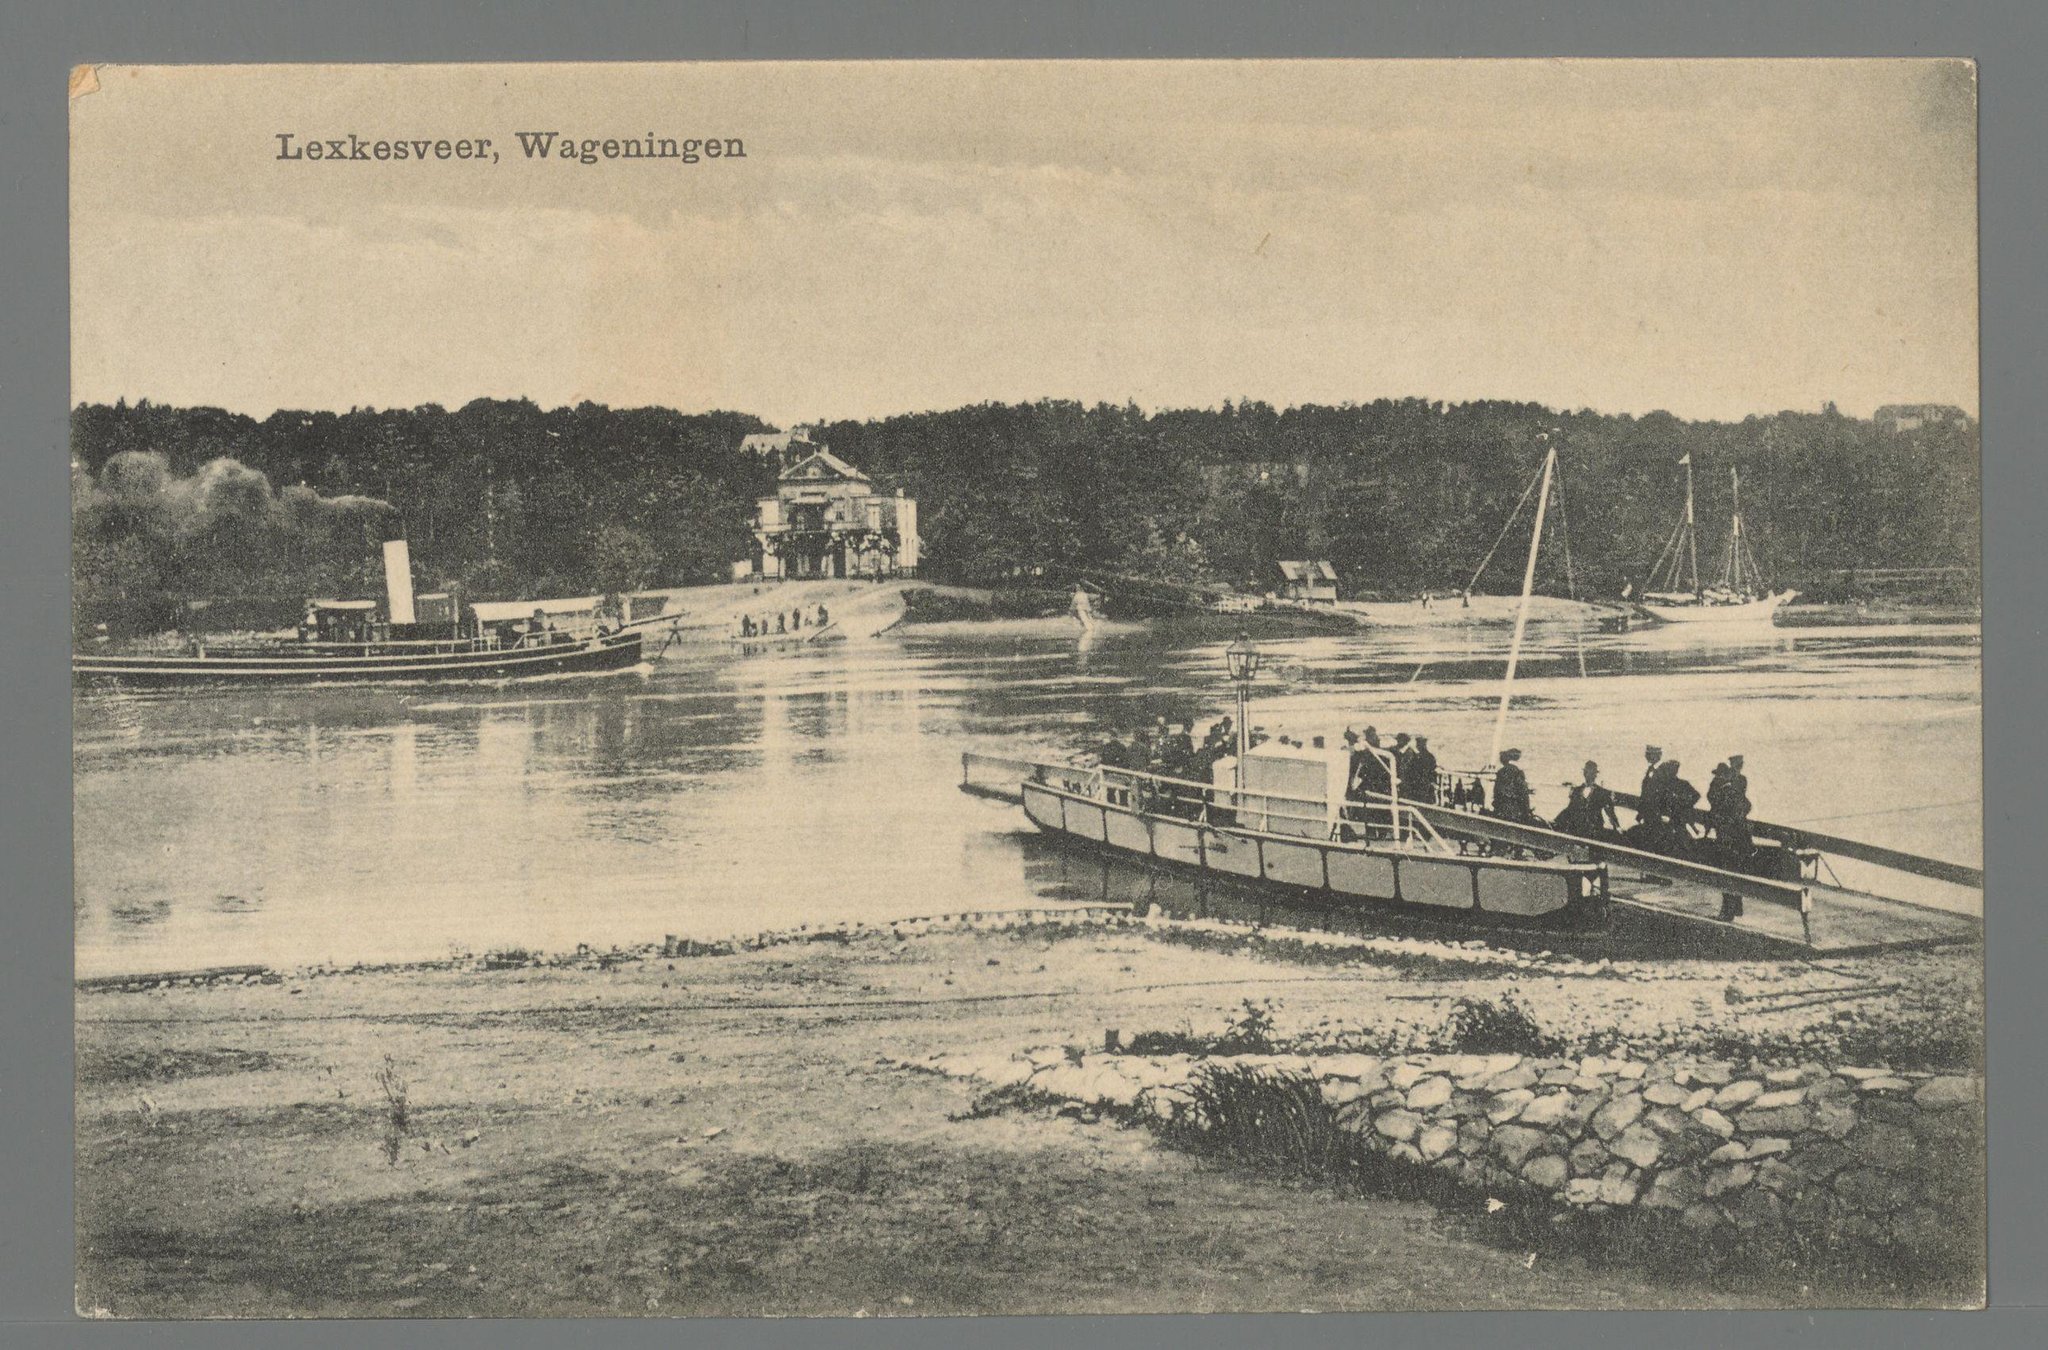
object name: photomechanical print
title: Lexkesveer, Wageningen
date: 1905-1920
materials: cardboard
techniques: photograph, writing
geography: wageningen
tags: river, ferry, lower rhine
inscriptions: postage stamp